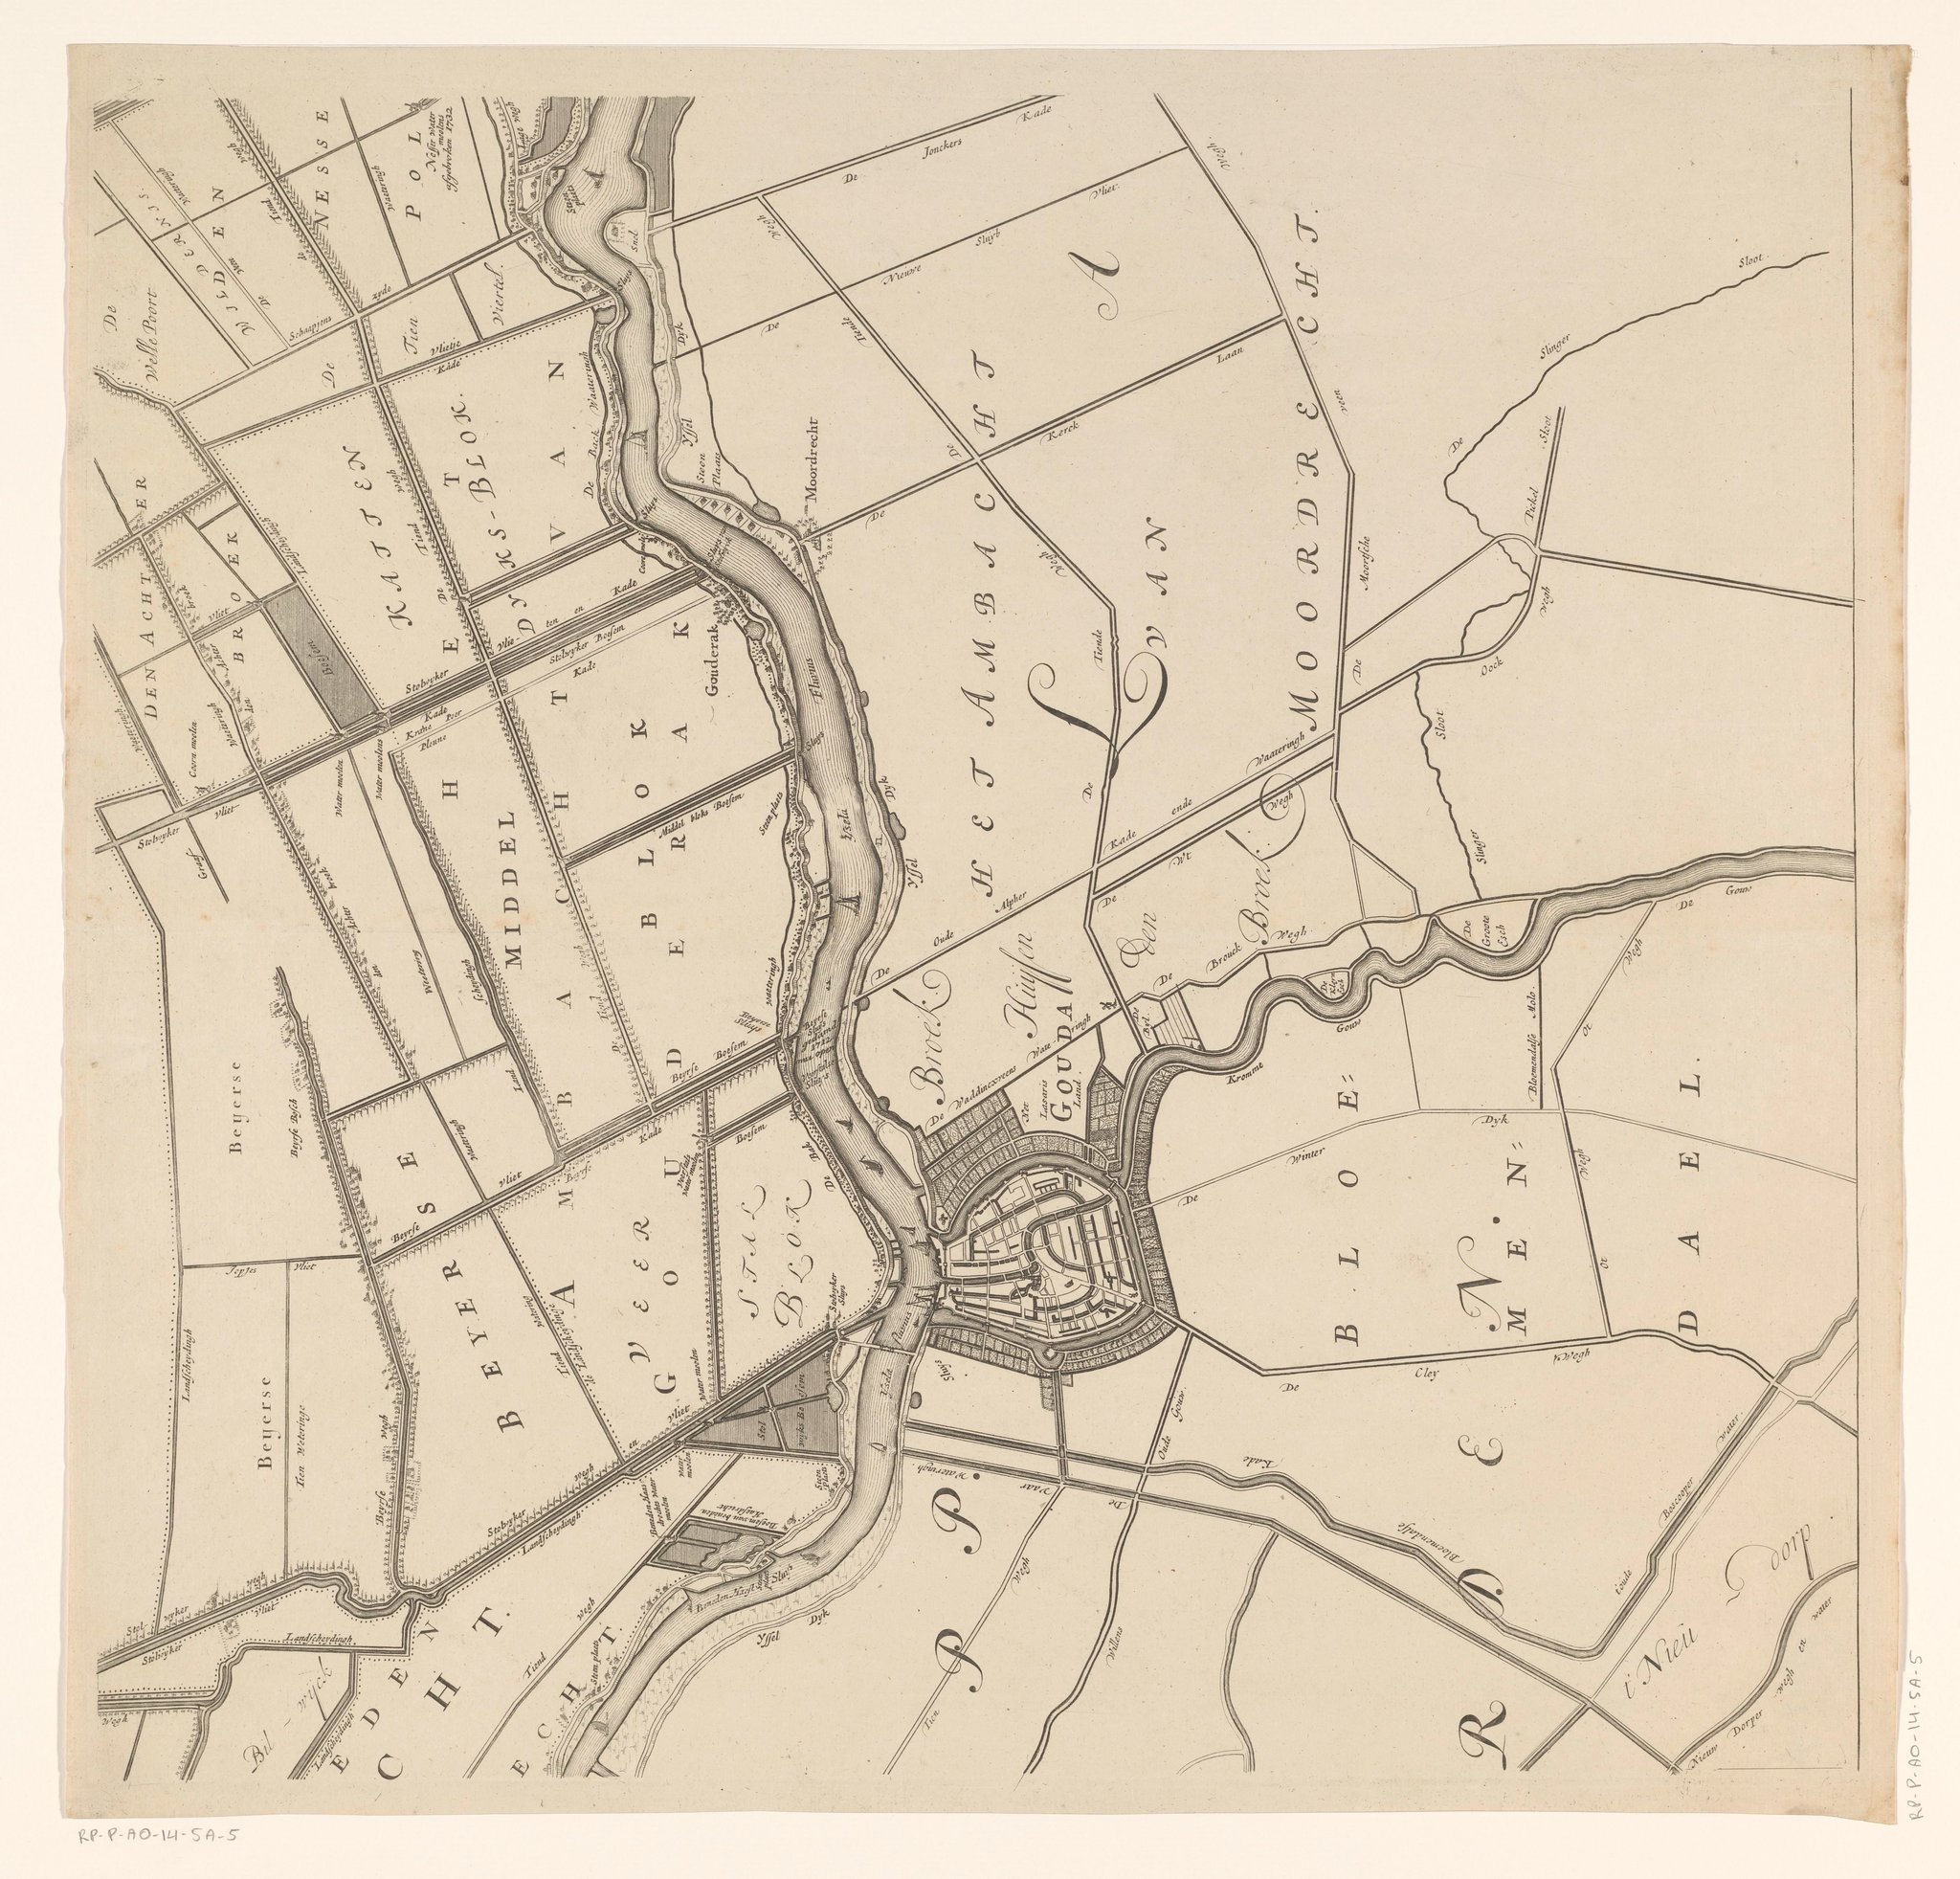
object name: print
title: Het Hooge Heemraadschap van de Crimpenre Waard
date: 1683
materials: paper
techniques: engraving, etching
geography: the hague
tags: maps of separate countries or regions, maps of cities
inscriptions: collector's mark: Lugt 19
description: Vijfde deel van de kaart van de zesde druk van 'Het Hooge Heemraadschap van de Crimpenre Waard', een wandkaart (bestaande uit een zesdelige kaart en een wapenrand) van het Hoogheemraadschap van de Krimpenerwaard.